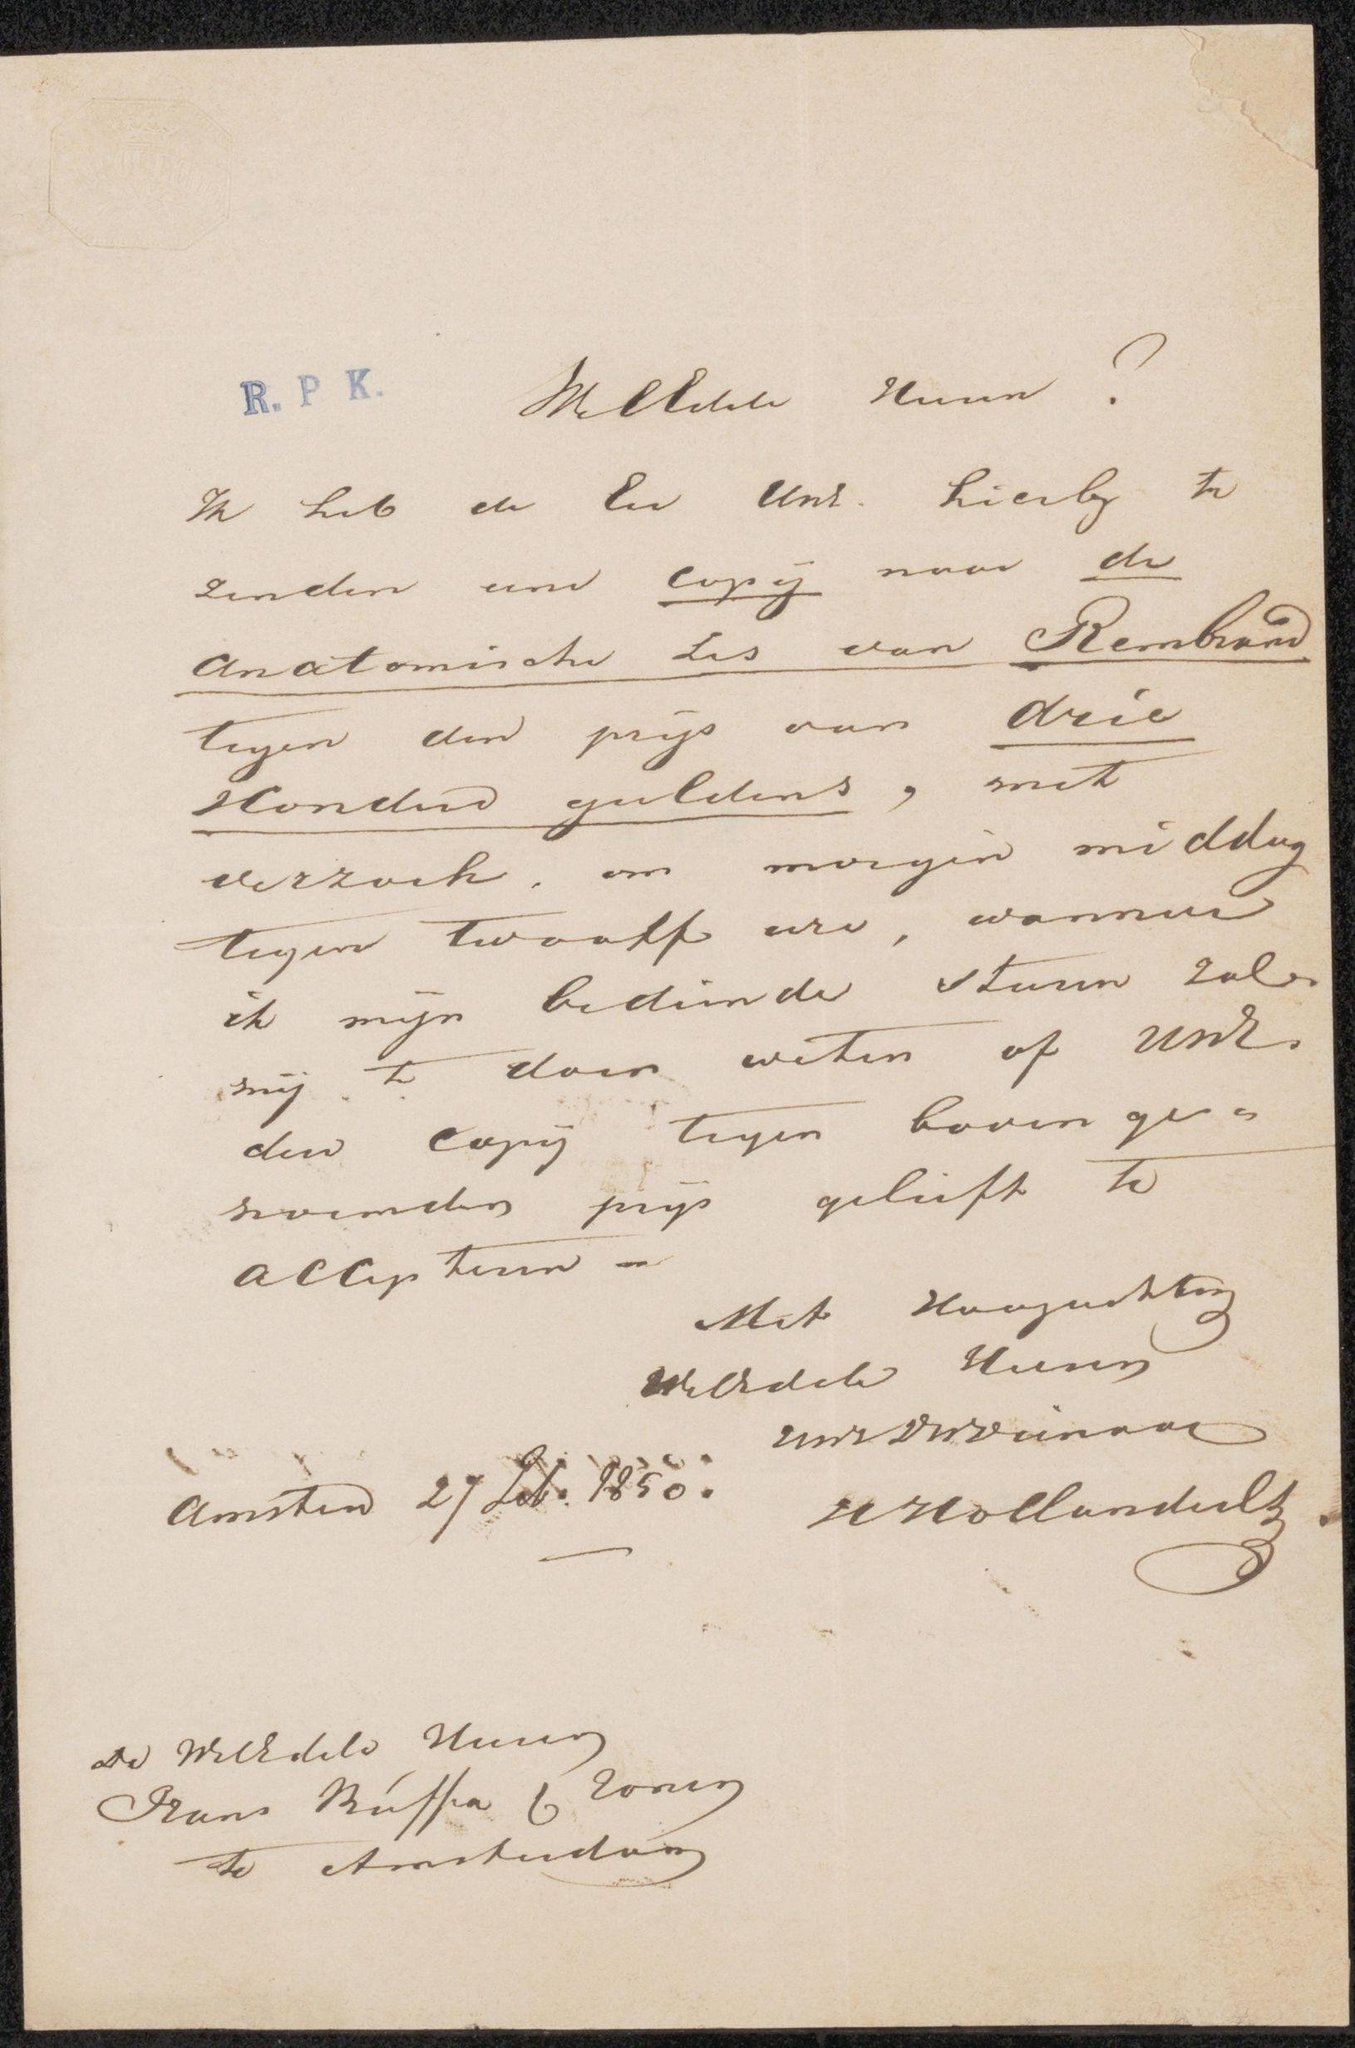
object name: letter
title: Brief aan Frans Buffa en Zonen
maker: hendrik hollander cz.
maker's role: painter, print maker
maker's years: 1823-1884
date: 1850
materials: ink, paper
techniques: pen, writing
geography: amsterdam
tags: publisher, amsterdam, painter, print maker, draughtsman, rembrandt van rijn, art trade, art shop, money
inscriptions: collector's mark: Lugt 2233